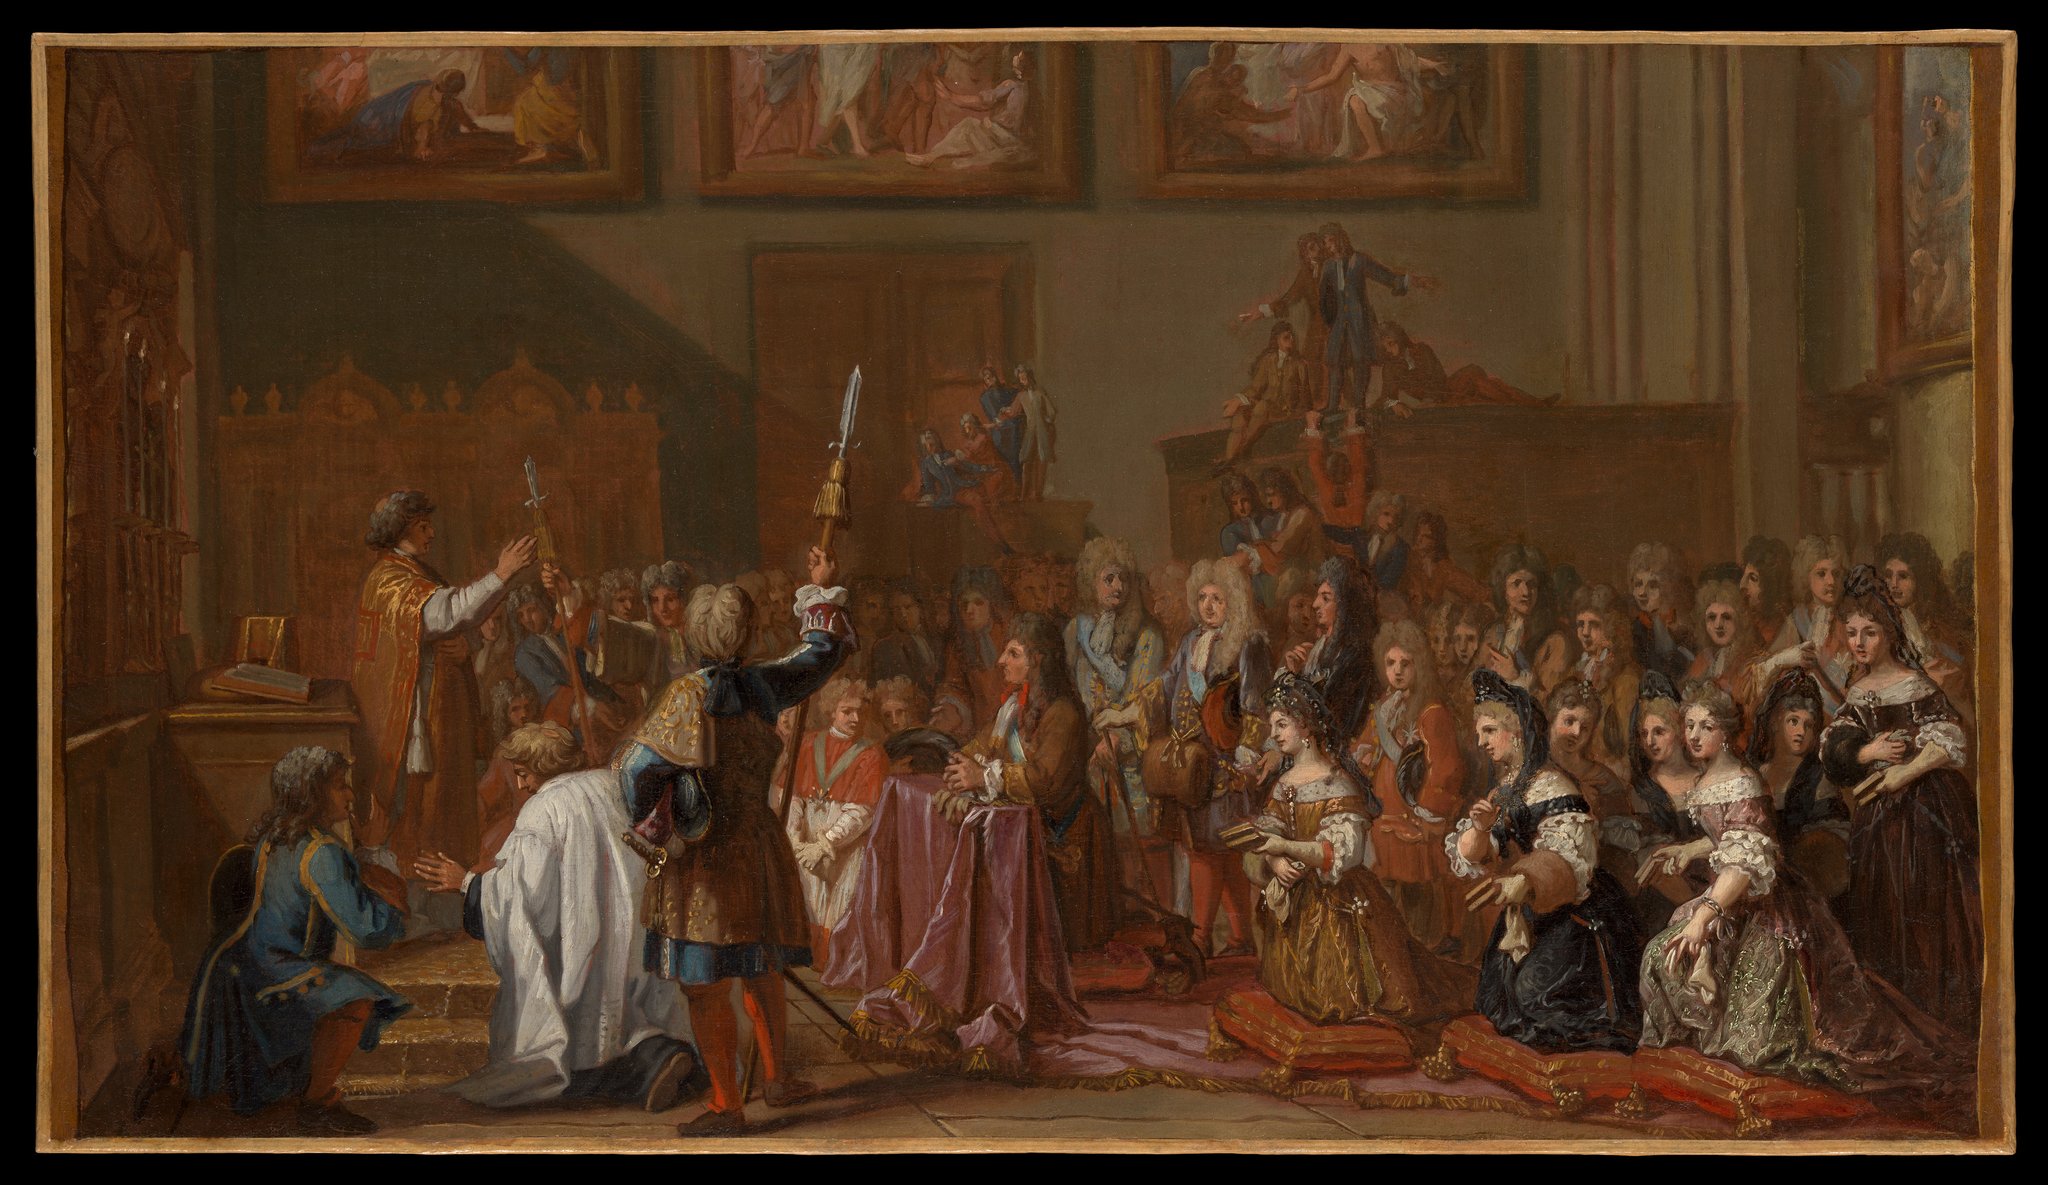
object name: drawing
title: Louis XIV in Notre-Dame de Paris on January 30, 1687 at a Thanksgiving Service after his Recovery from a Grave Illness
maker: guy louis vernansal the elder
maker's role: artist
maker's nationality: french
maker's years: 1648-1729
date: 1710-1715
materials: canvas, oil, paper